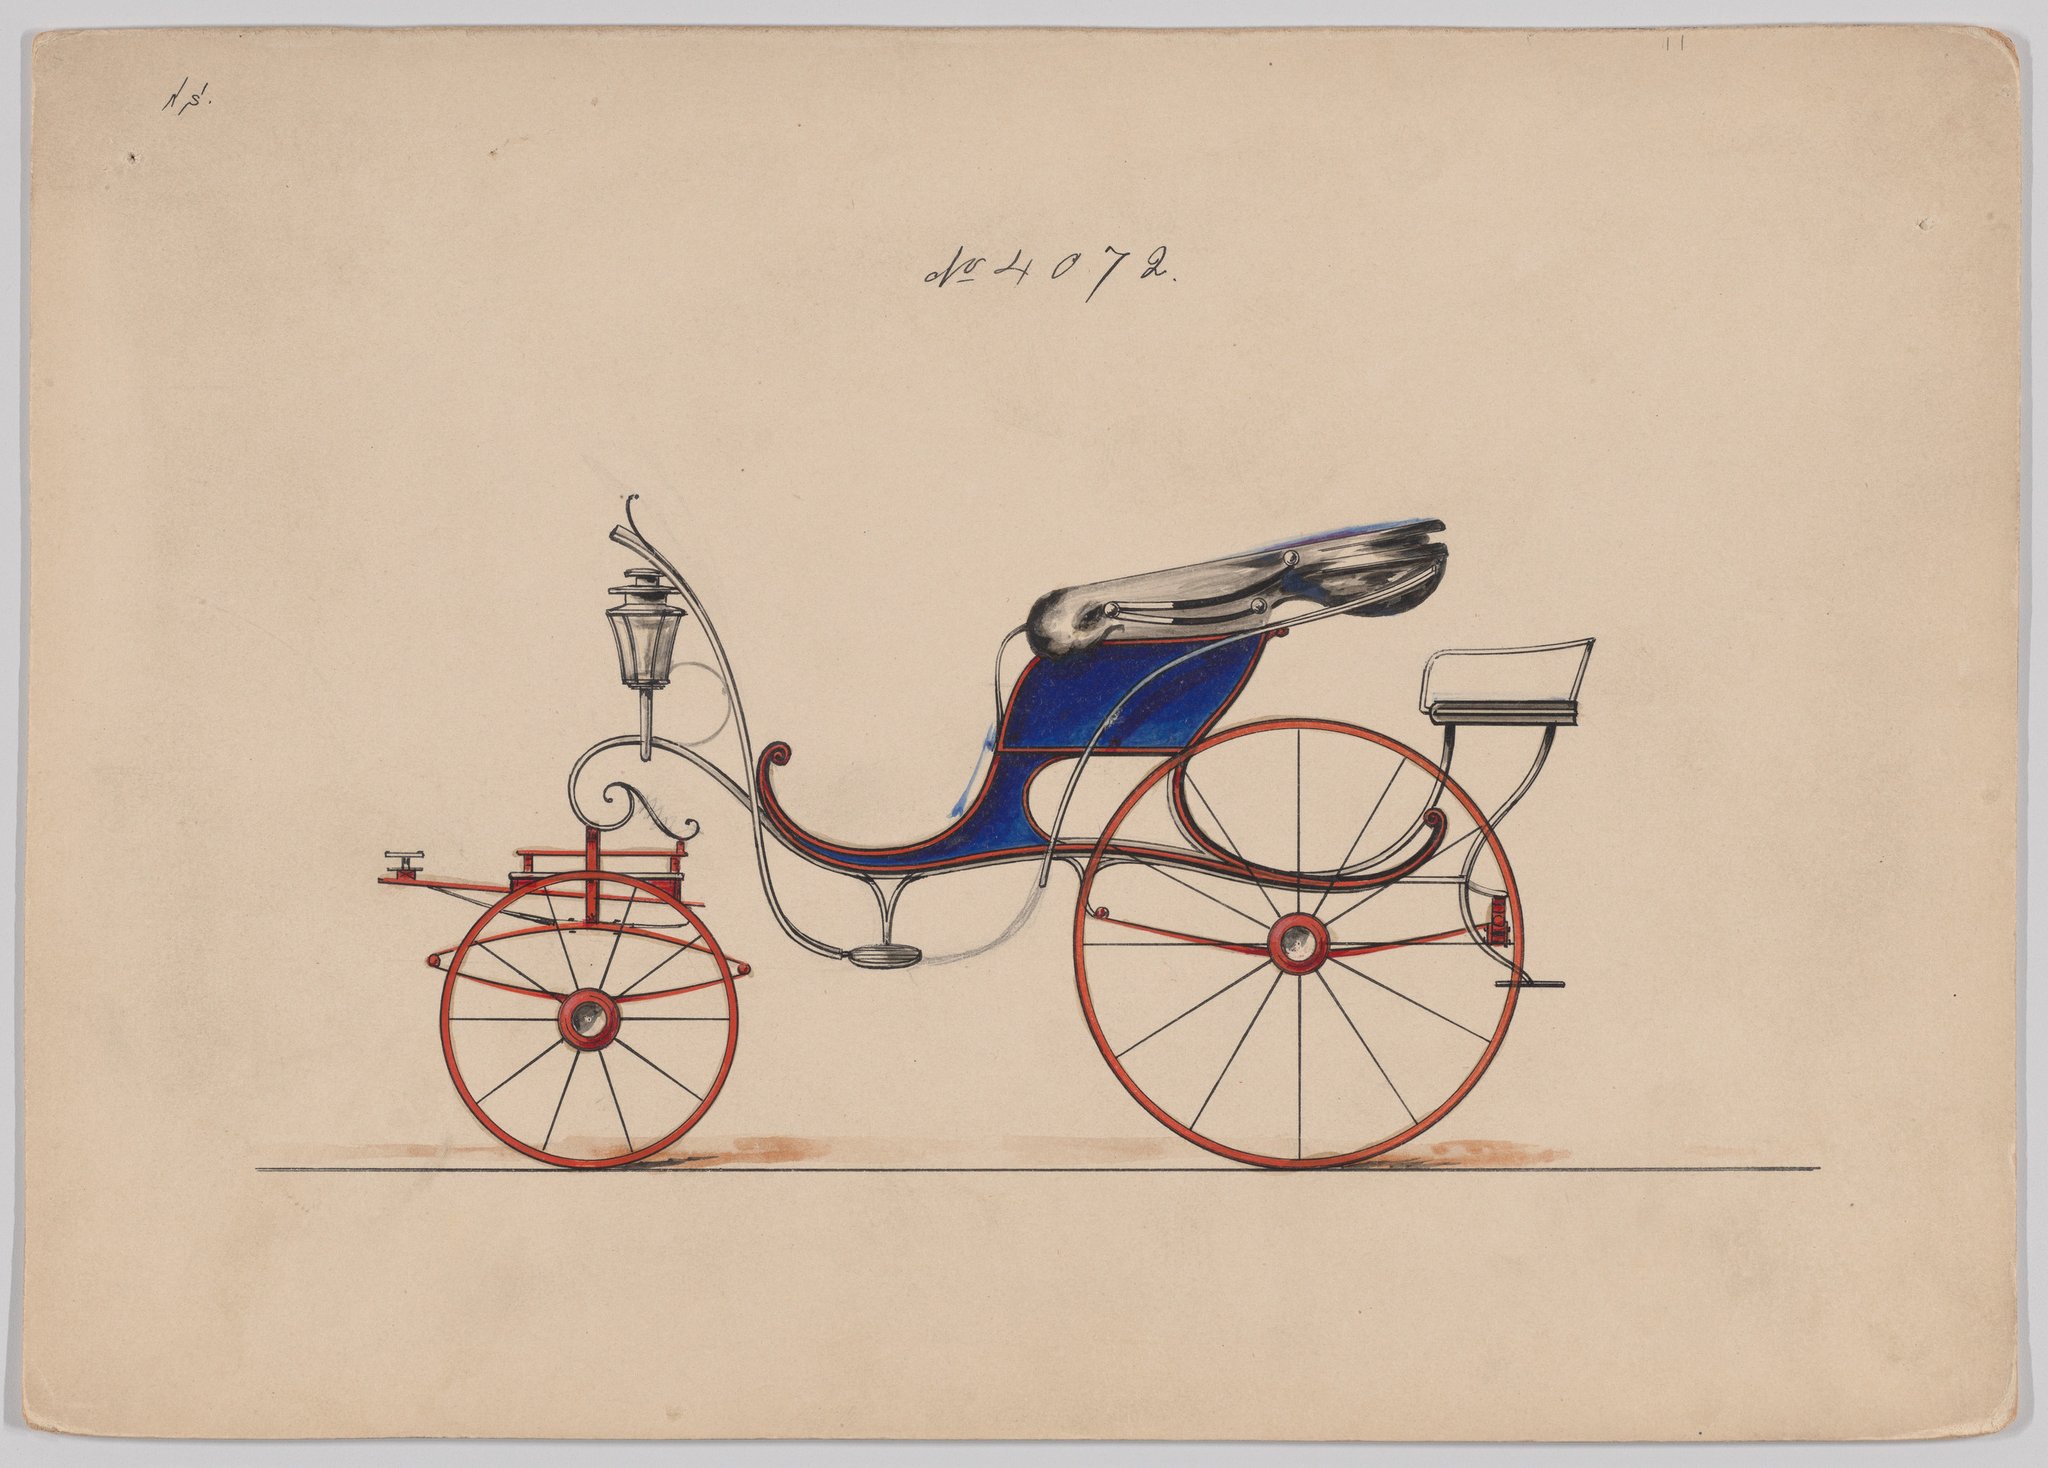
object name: drawing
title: Design for Pony Phaeton, no. 4072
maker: brewster & co.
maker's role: manufacturer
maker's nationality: american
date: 1890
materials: gouache, gum arabic, ink, watercolor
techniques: pen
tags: carriages